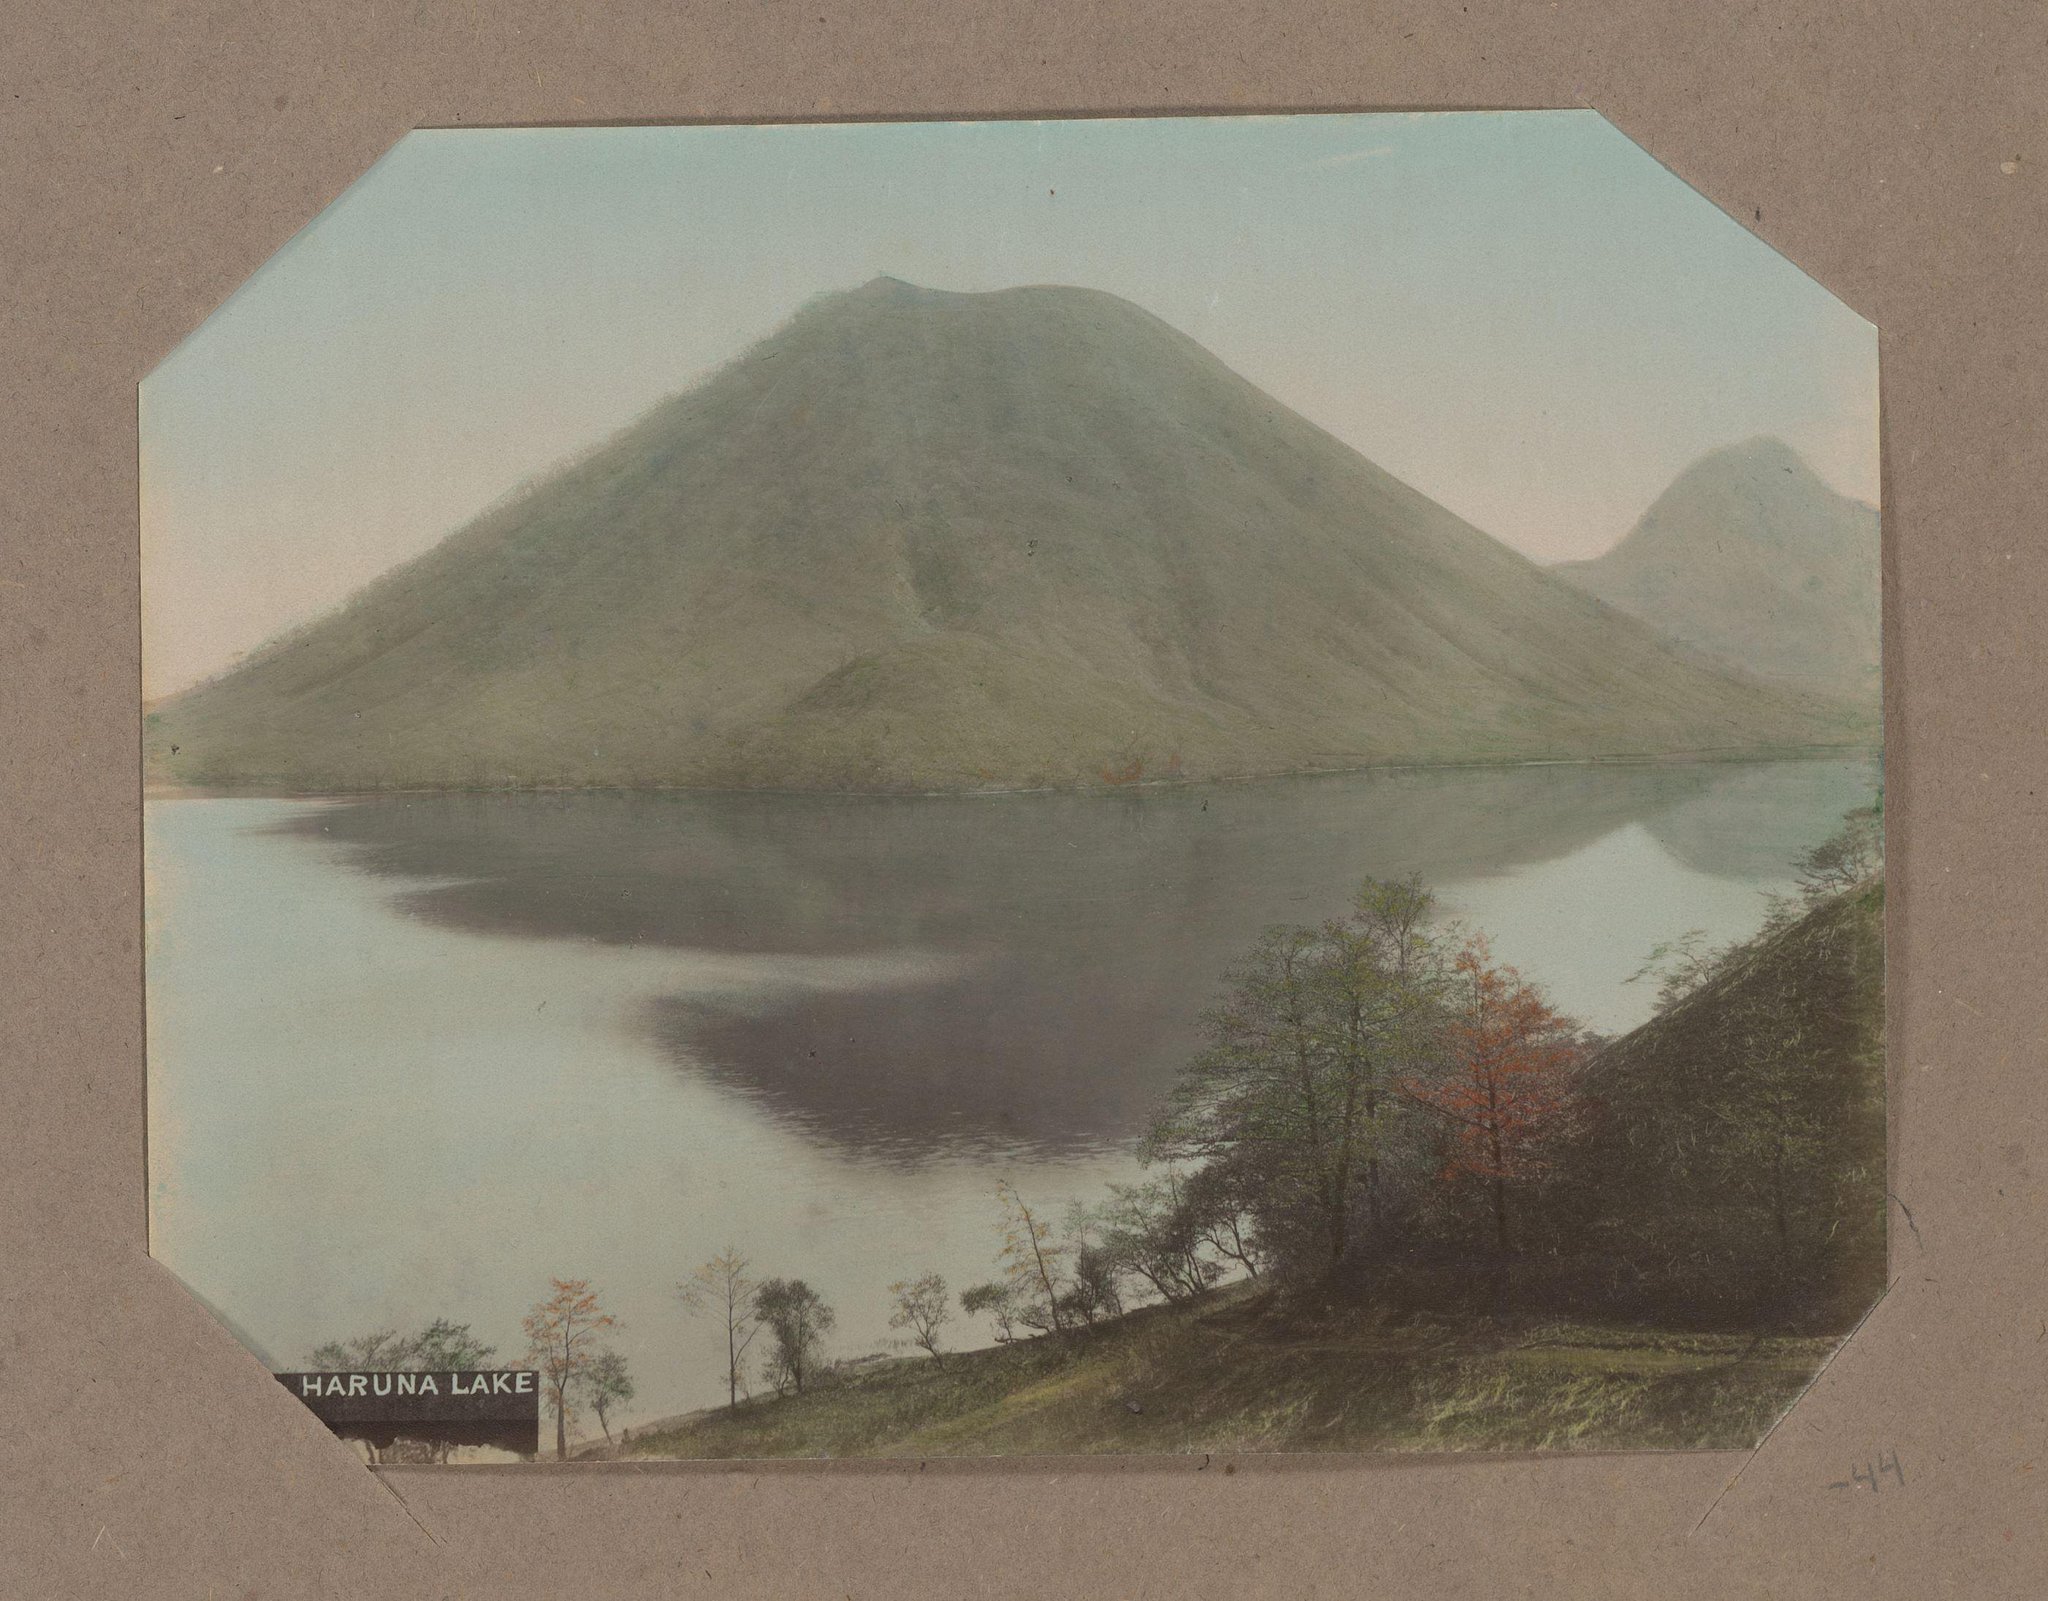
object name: photograph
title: Gezicht op het Haruna meer, Japan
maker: Anonymous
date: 1890-1903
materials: paper, photographic support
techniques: albumen print, hand coloring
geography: haruna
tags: lake, mountains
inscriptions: inscription: ‘817 Haruna Lake’